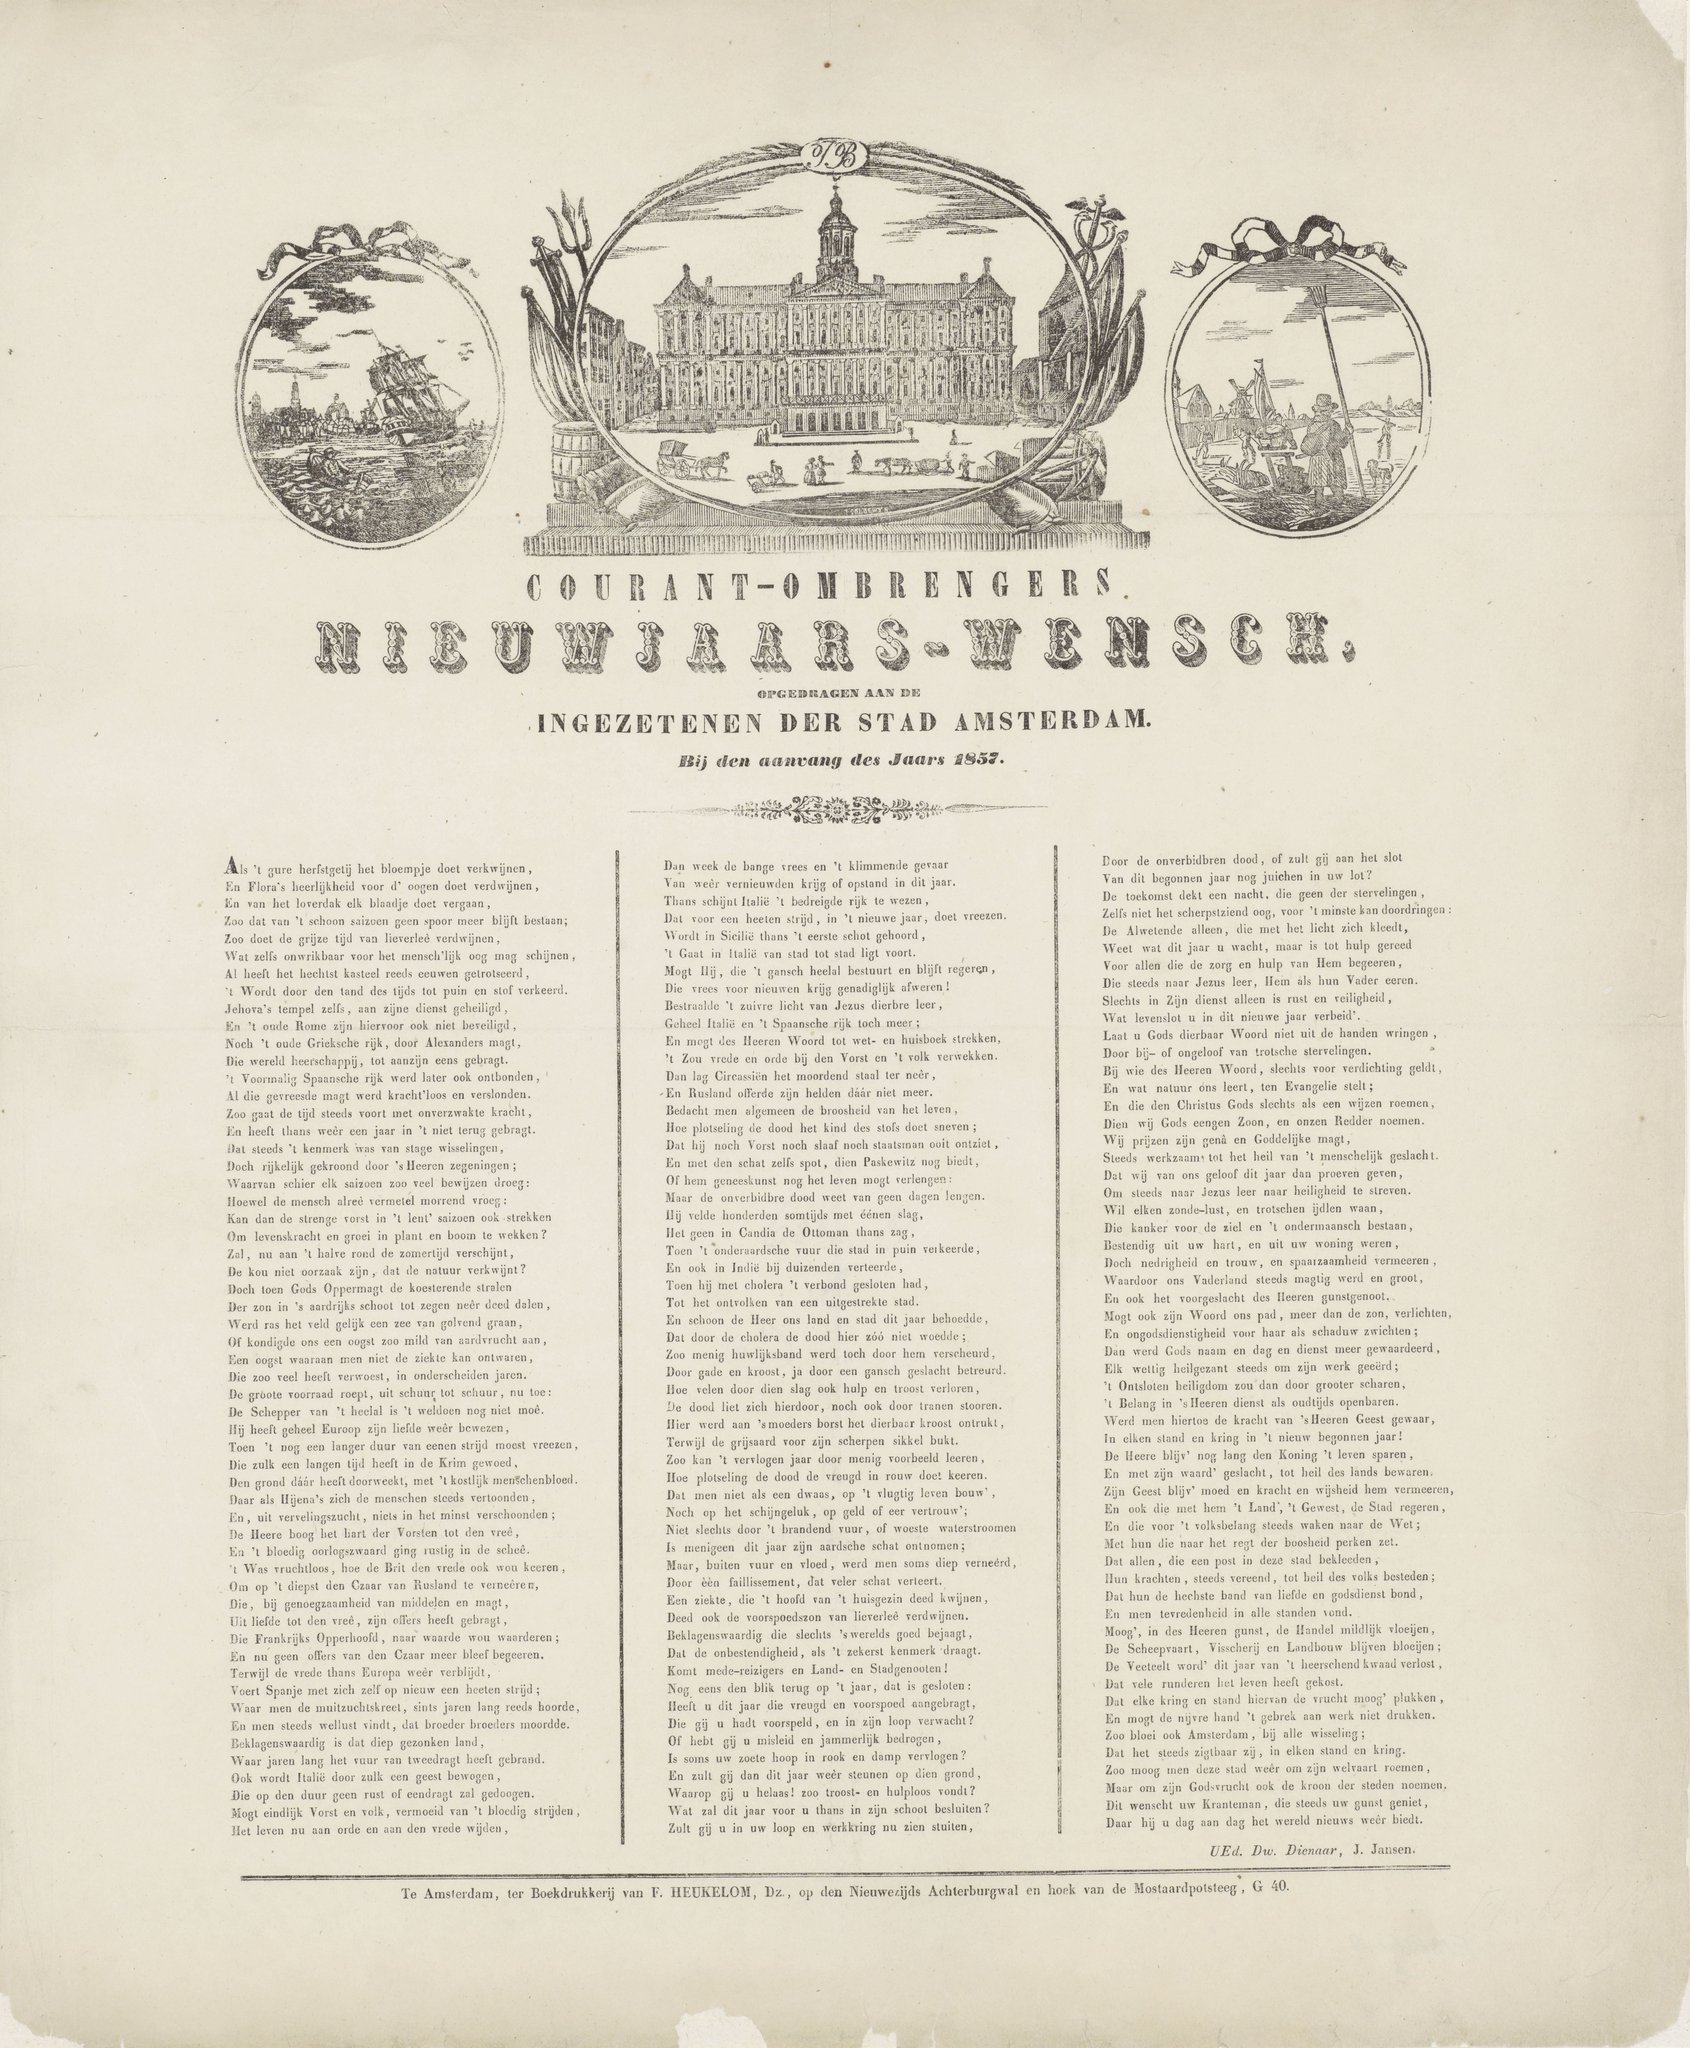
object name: new year card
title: Nieuwjaarswens van de Amsterdamse courantombrengers voor het jaar 1857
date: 1856-1857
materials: paper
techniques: letterpress printing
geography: amsterdam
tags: delivery (of newspaper), skates (winter sports), street, royal palace of amsterdam, amsterdam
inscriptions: collector's mark: Lugt 2228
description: Nieuwjaarswens namens de ombrengers van couranten (krantenbezorgers) te Amsterdam voor het jaar 1857. Bovenaan drie medaillons met centraal een gezicht op het Paleis op de Dam, links een schip op het IJ, rechts ijsvermaak buiten de stadswal. Onderaan een gedicht in drie kolommen. Van de courantombrenger: J. Jansen.